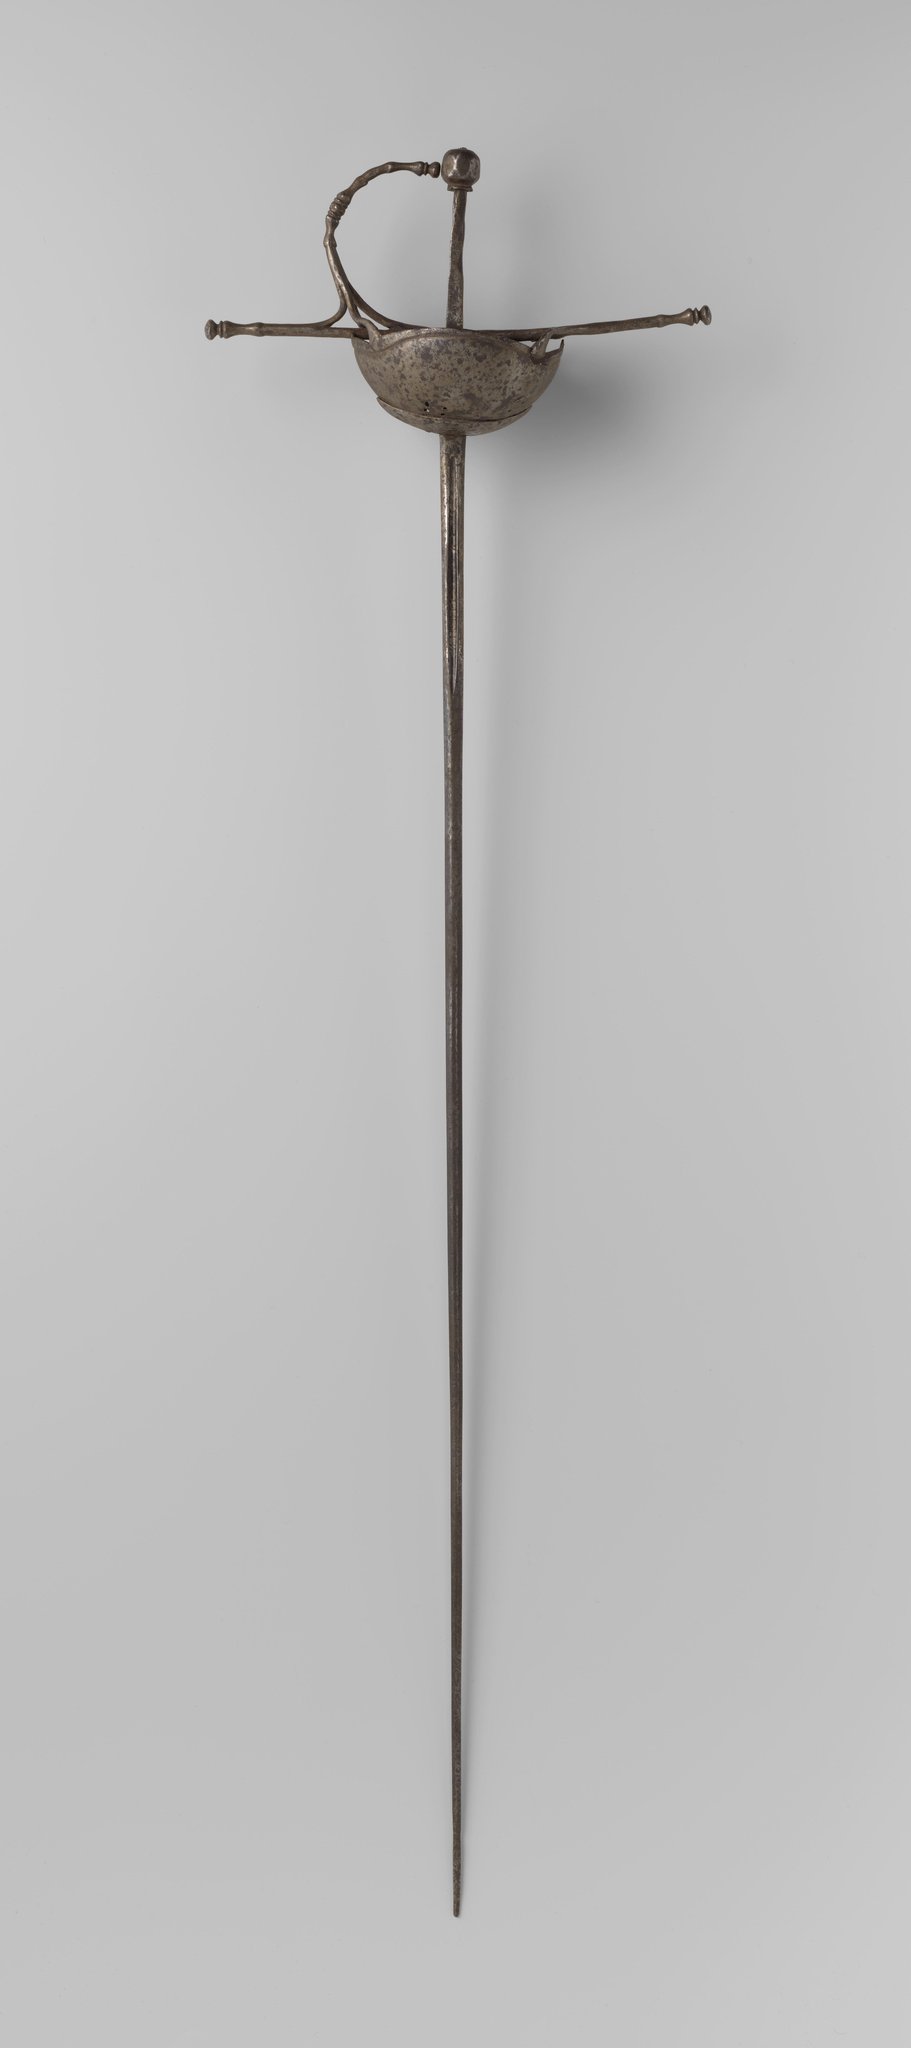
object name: rapier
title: Rapier met gesloten korf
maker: Anonymous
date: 1600-1699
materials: iron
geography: solingen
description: Rapier met ijzeren gevest. Ronde knop met negen ruiten. Balustervormige voorbeugel met twee zijbeugels welke gesmeed zijn aan de halve korf. Pareerstang met ballustervormige knoppen. Aan de andere zijde van de pareertstang zijn twee zijbeugels aan de korf aangebracht. Puntvormige ricasso. Rechte tweesnijdende pareerstang met aan beide zijden een geul, waarin gegraveerd aan beide zijden: xx I Z xx SOLINGEN [?] xx.